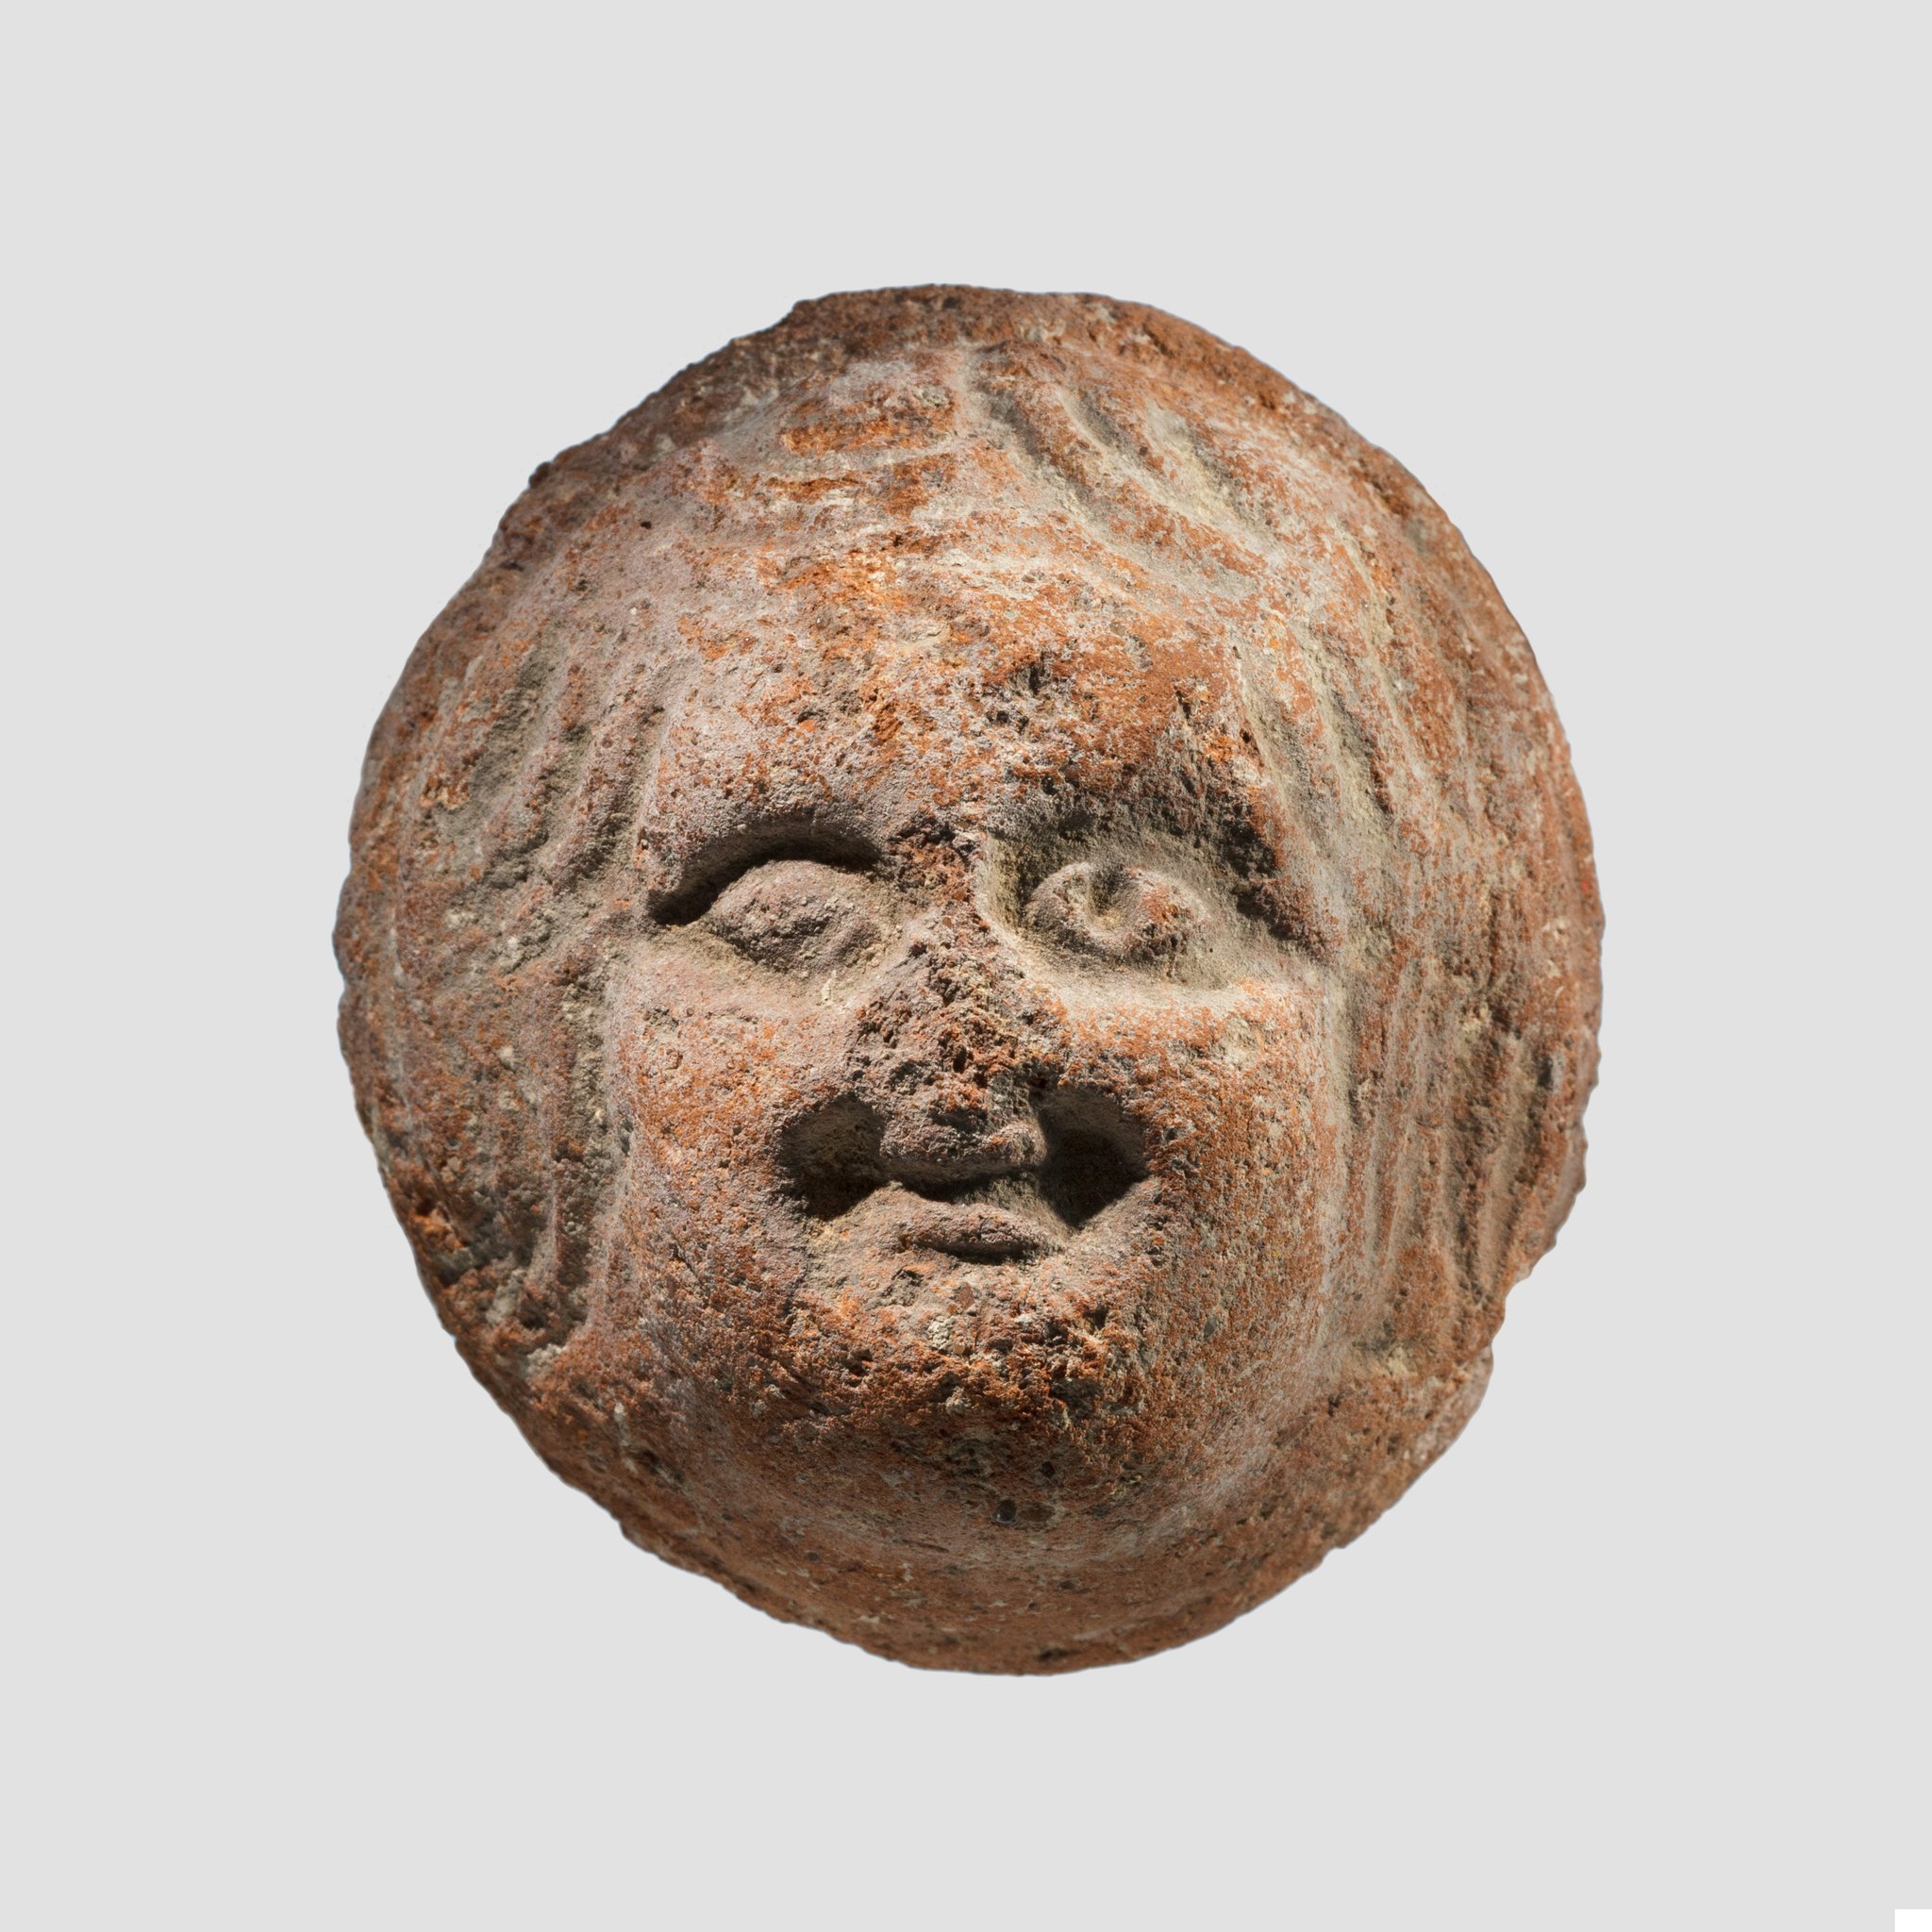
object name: medallion, face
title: Medallion?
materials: terracotta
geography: egypt